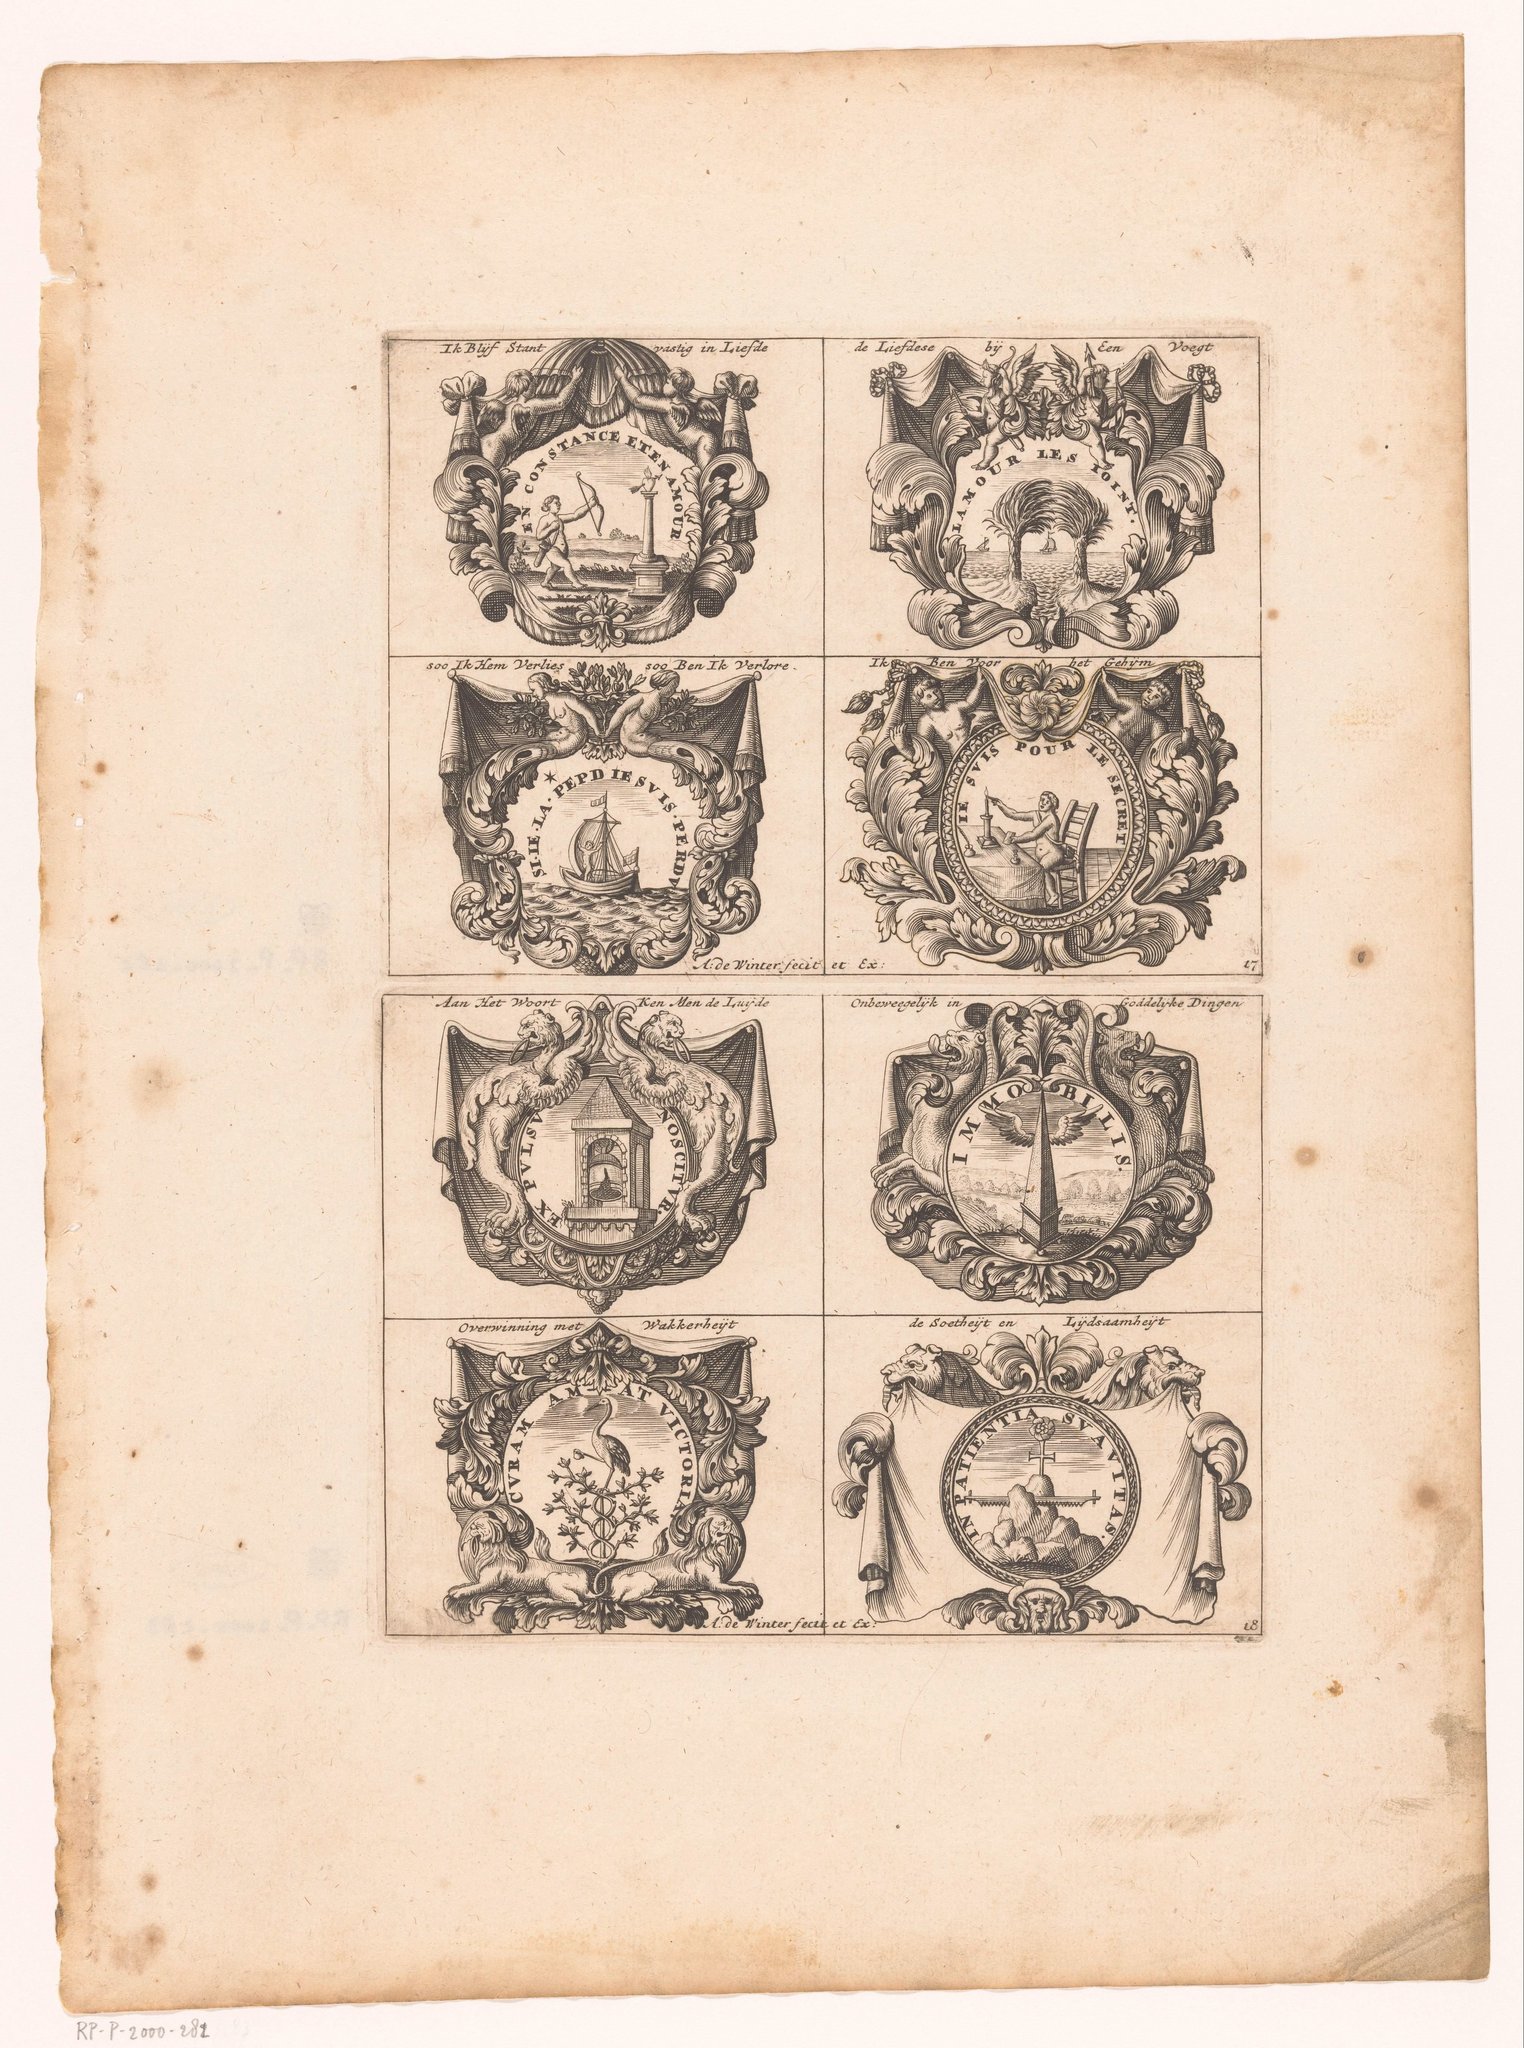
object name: print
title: Verscheijde Nieuwe en Seer Aardige Geinventeertde Compartemente en Sinrijcke Emblemataas of Sinnebeelden seer Dien stigh voor Silversmeeden (...) Twede Deel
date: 1697-1718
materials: paper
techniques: engraving, etching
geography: amsterdam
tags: parts of church exterior and annexes: campanile, obelisk, needle, (story of) cupid, amor (eros), abstract ideas and concepts (+ emblematical representation of concept)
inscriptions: collector's mark: Lugt 2228, collector's mark: Lugt 2760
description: Tweemaal vier emblemata met Nederlandse tekst en Latijns motto op een blad. Boven: Emblemata met Amor schietend met pijl en boog, twee naar elkaar buigende palmbomen, Amor in een zeilboot op zee en Amor met een brief. Onder: Emblemata met een klokkentoren met kapotte bel, een gevleugelde obelisk, een ooievaar op ranken en een rot met bloem, kruis en zaag.